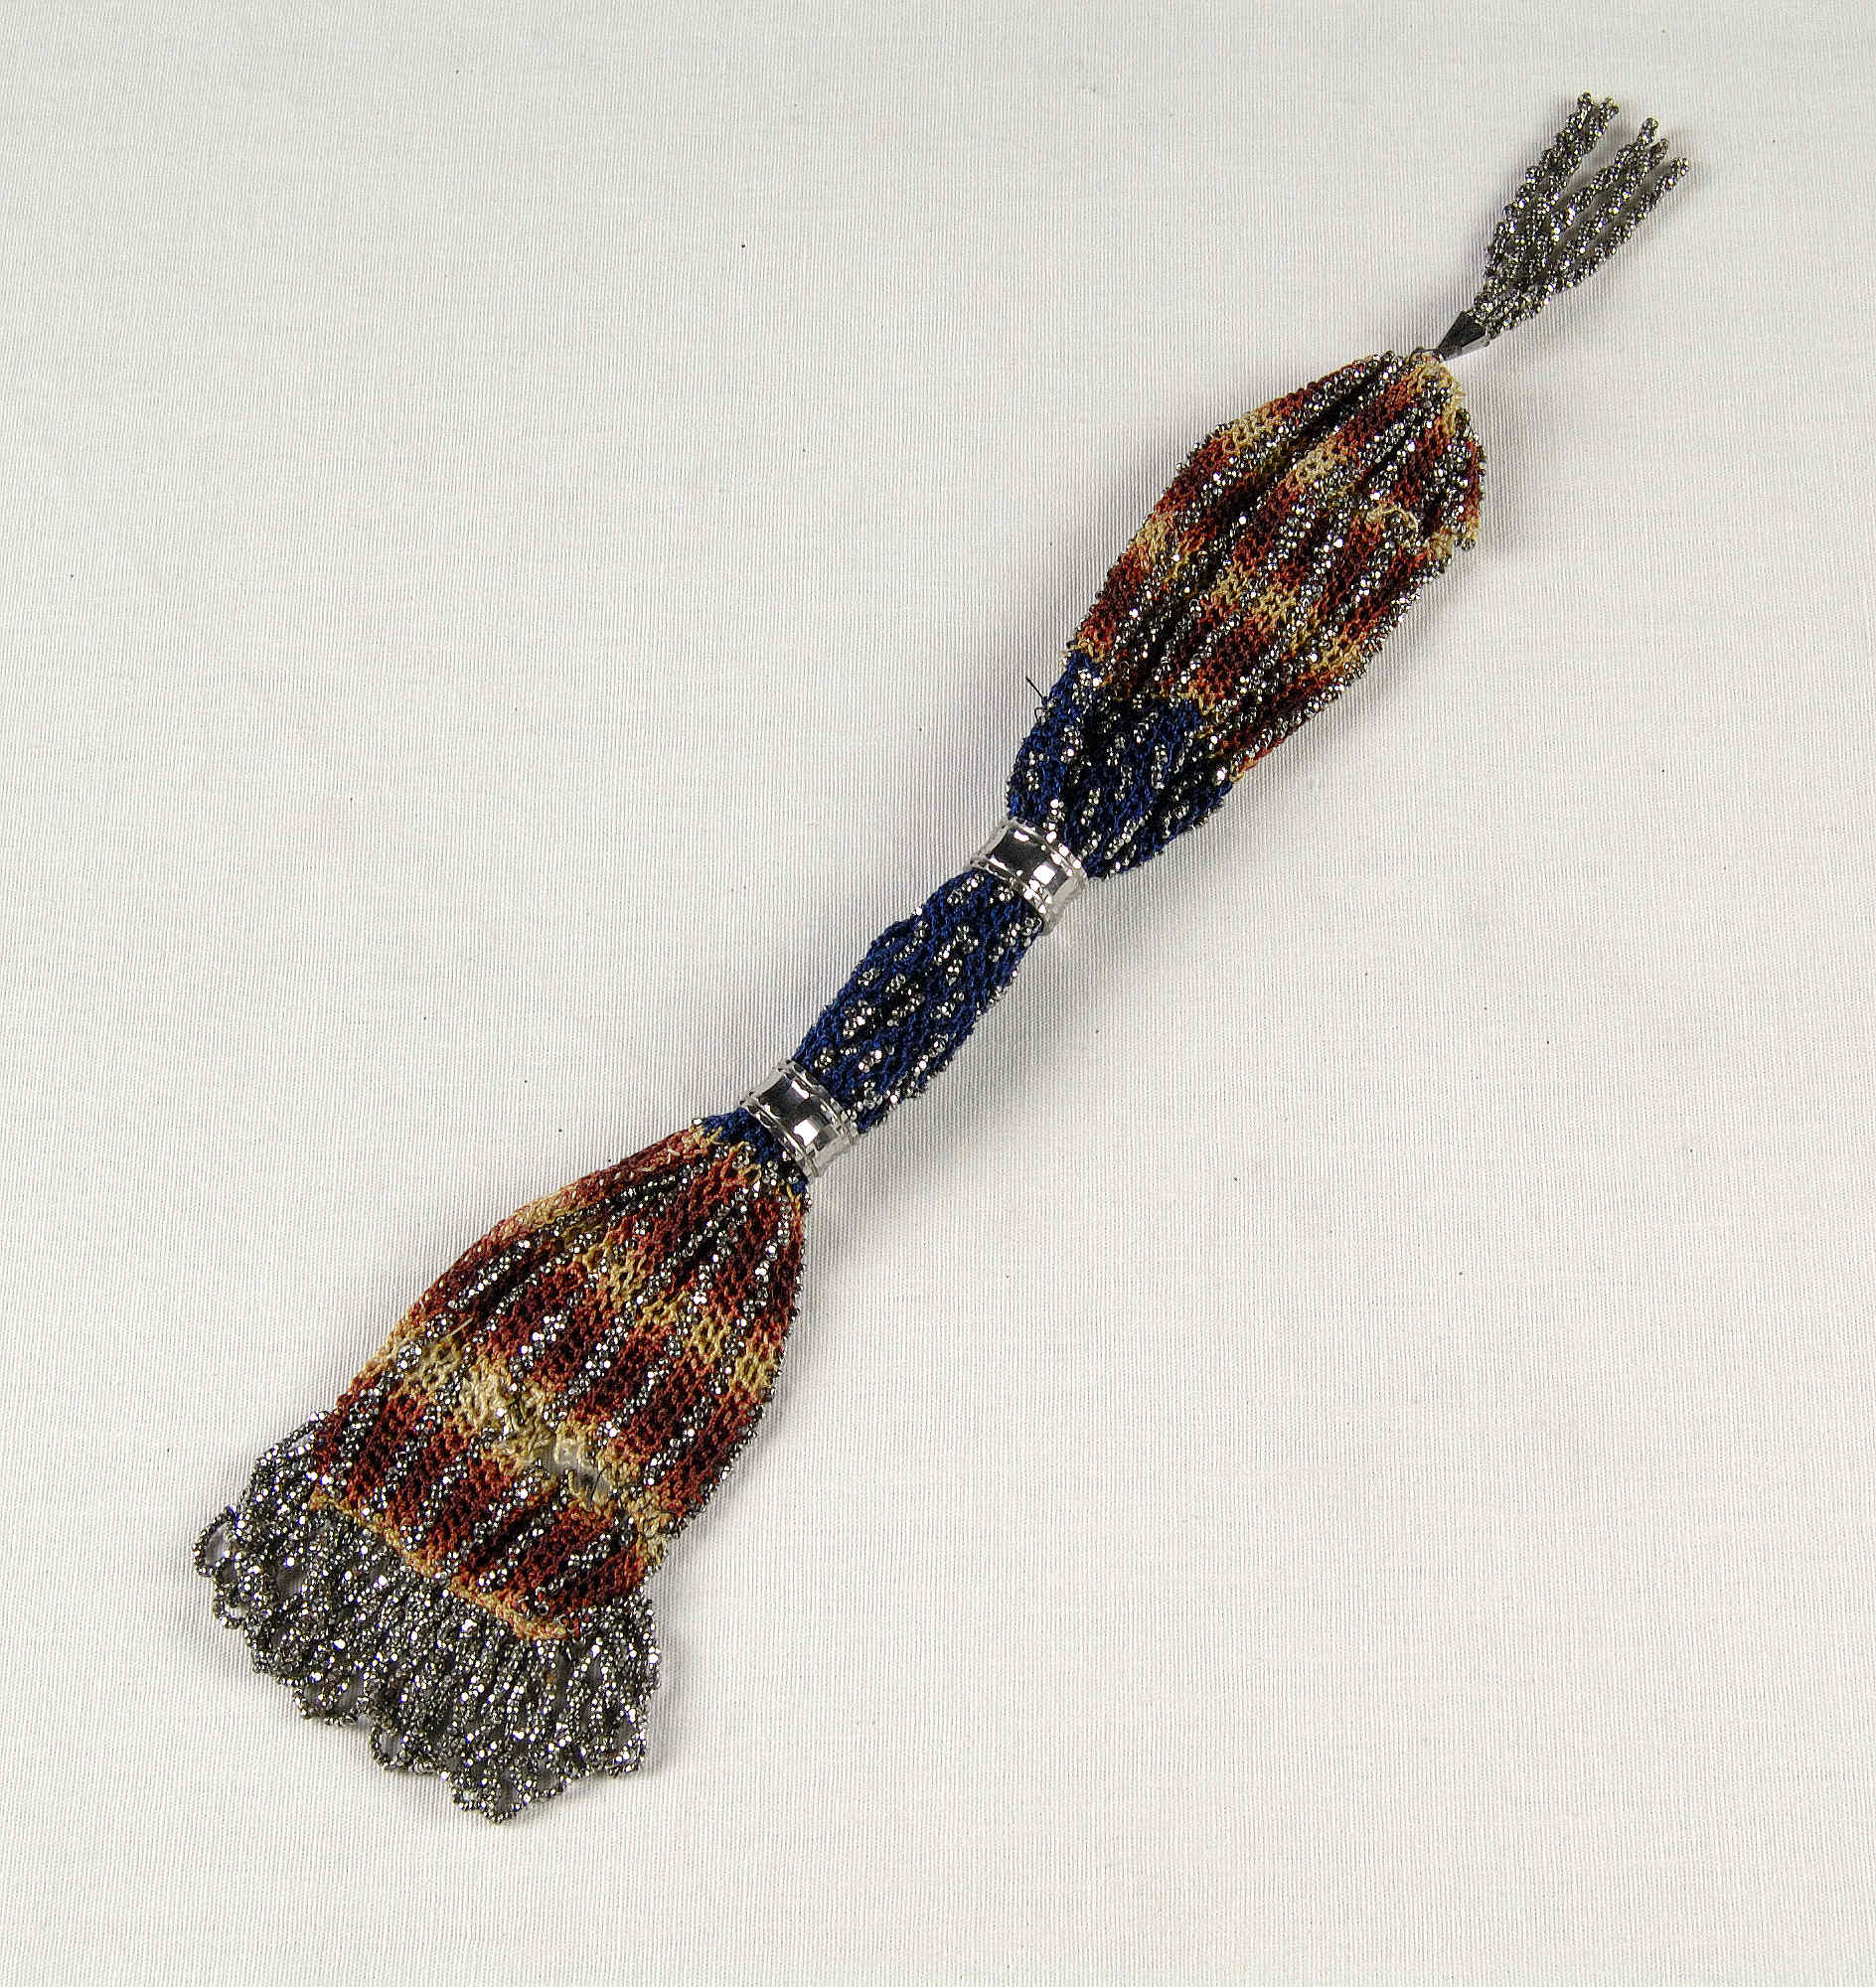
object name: miser's purse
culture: american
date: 1867-1900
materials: metal, silk